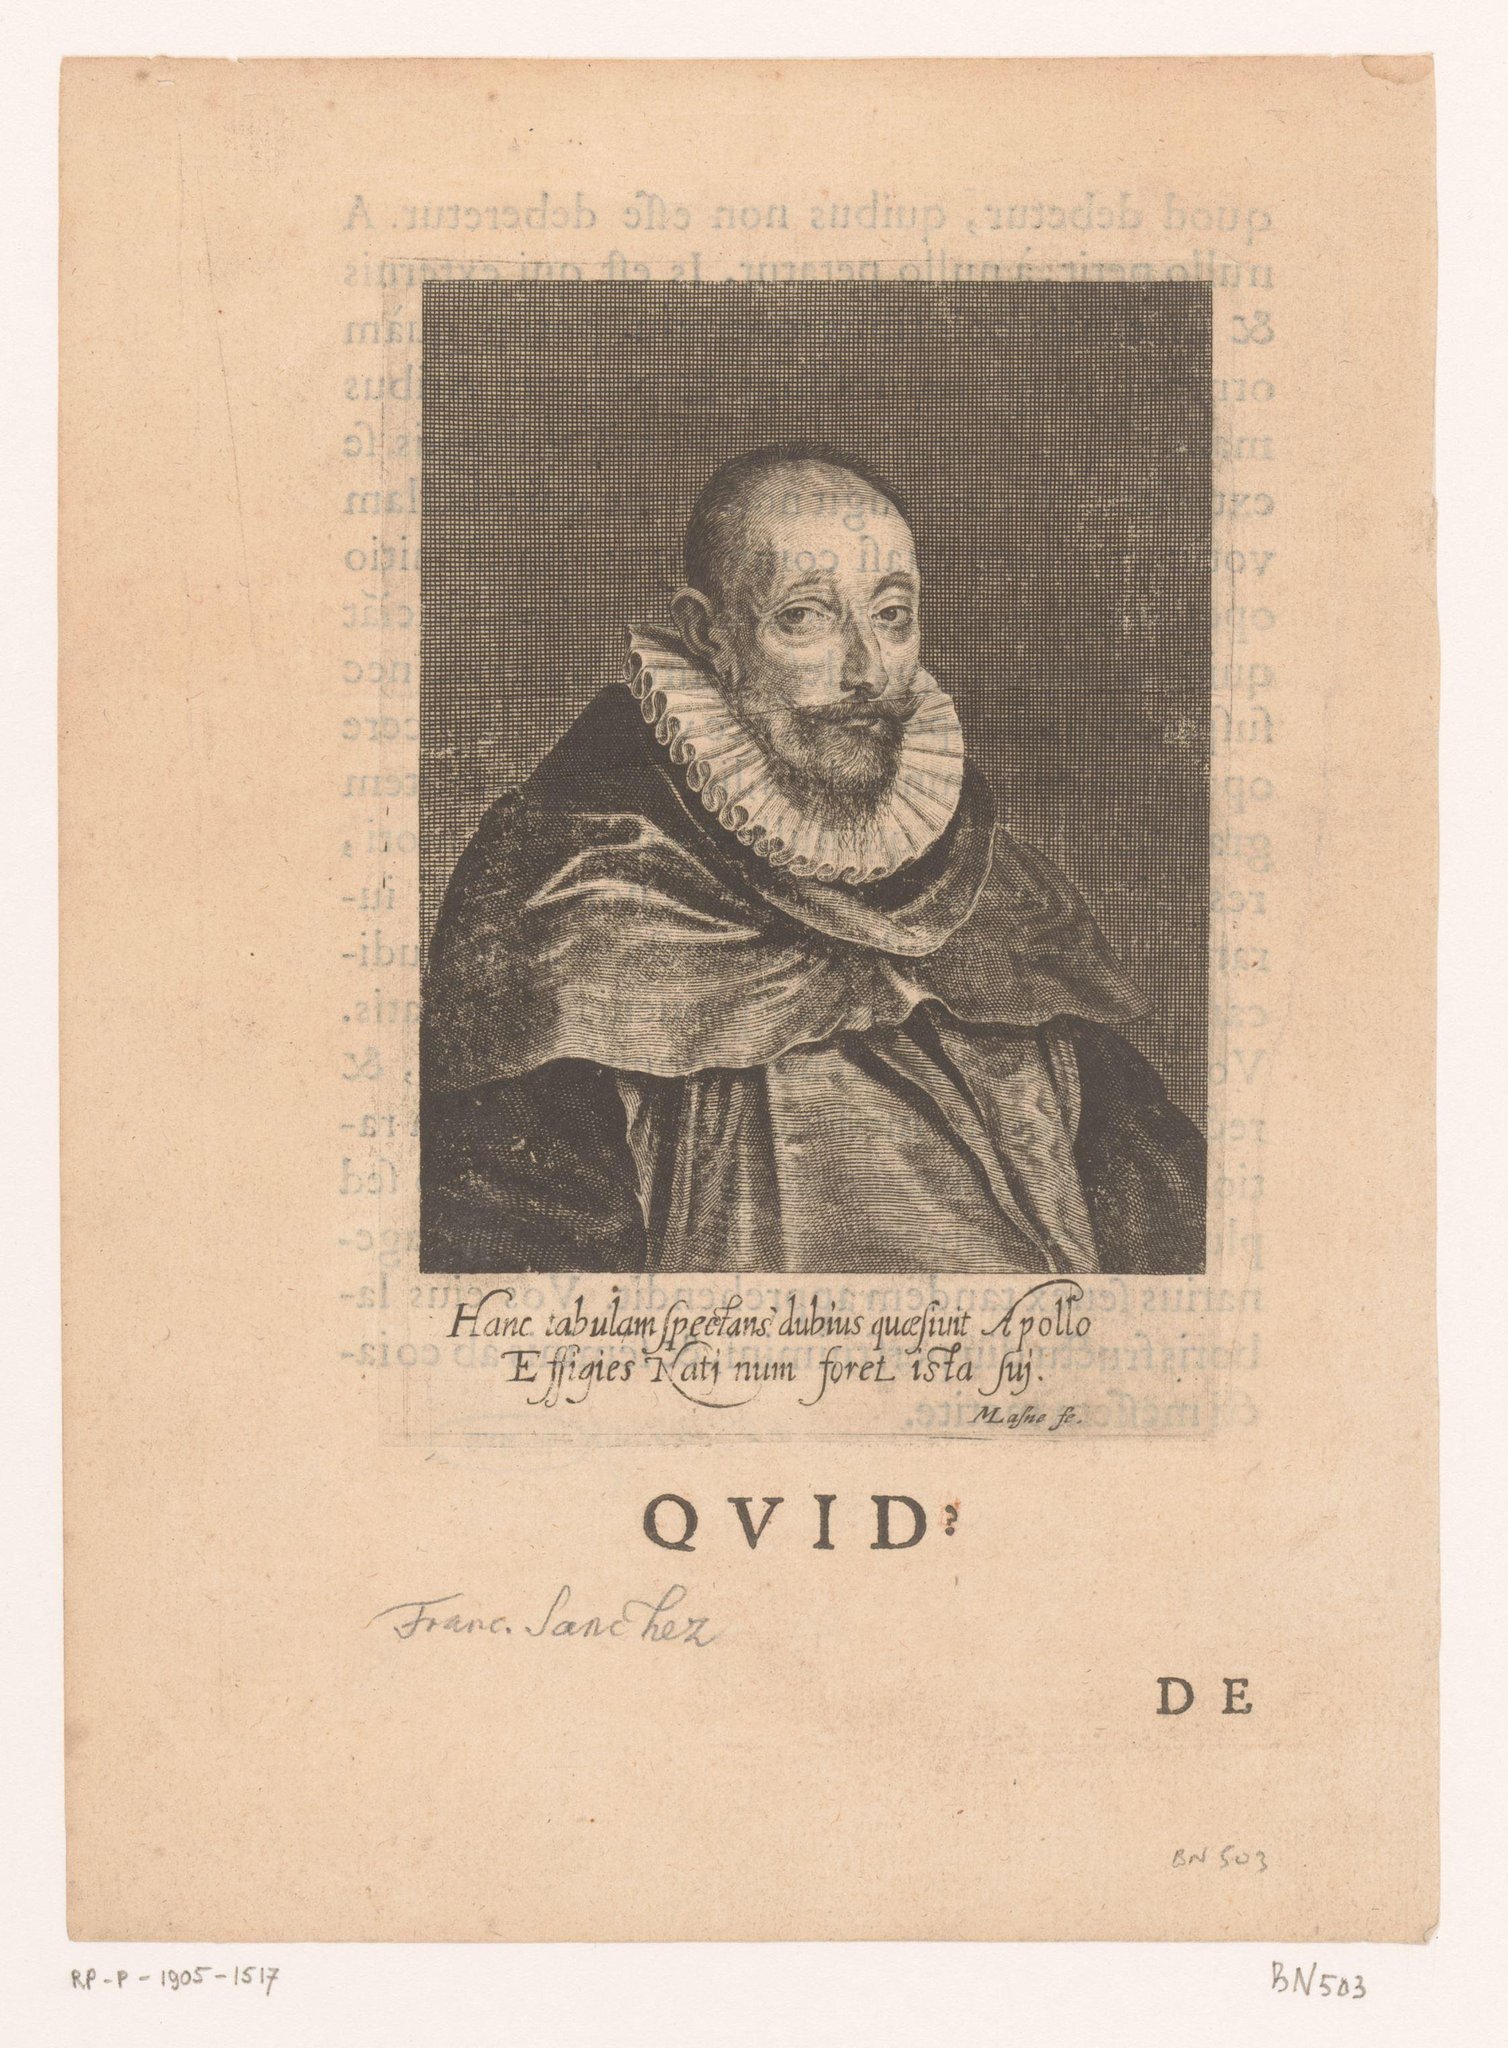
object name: print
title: Portret van François Sanchez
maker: michel lasne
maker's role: print maker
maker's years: 1590-1667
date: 1600-1667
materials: paper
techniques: engraving, letterpress printing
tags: historical persons, physician, doctor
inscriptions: collector's mark: Lugt 2228